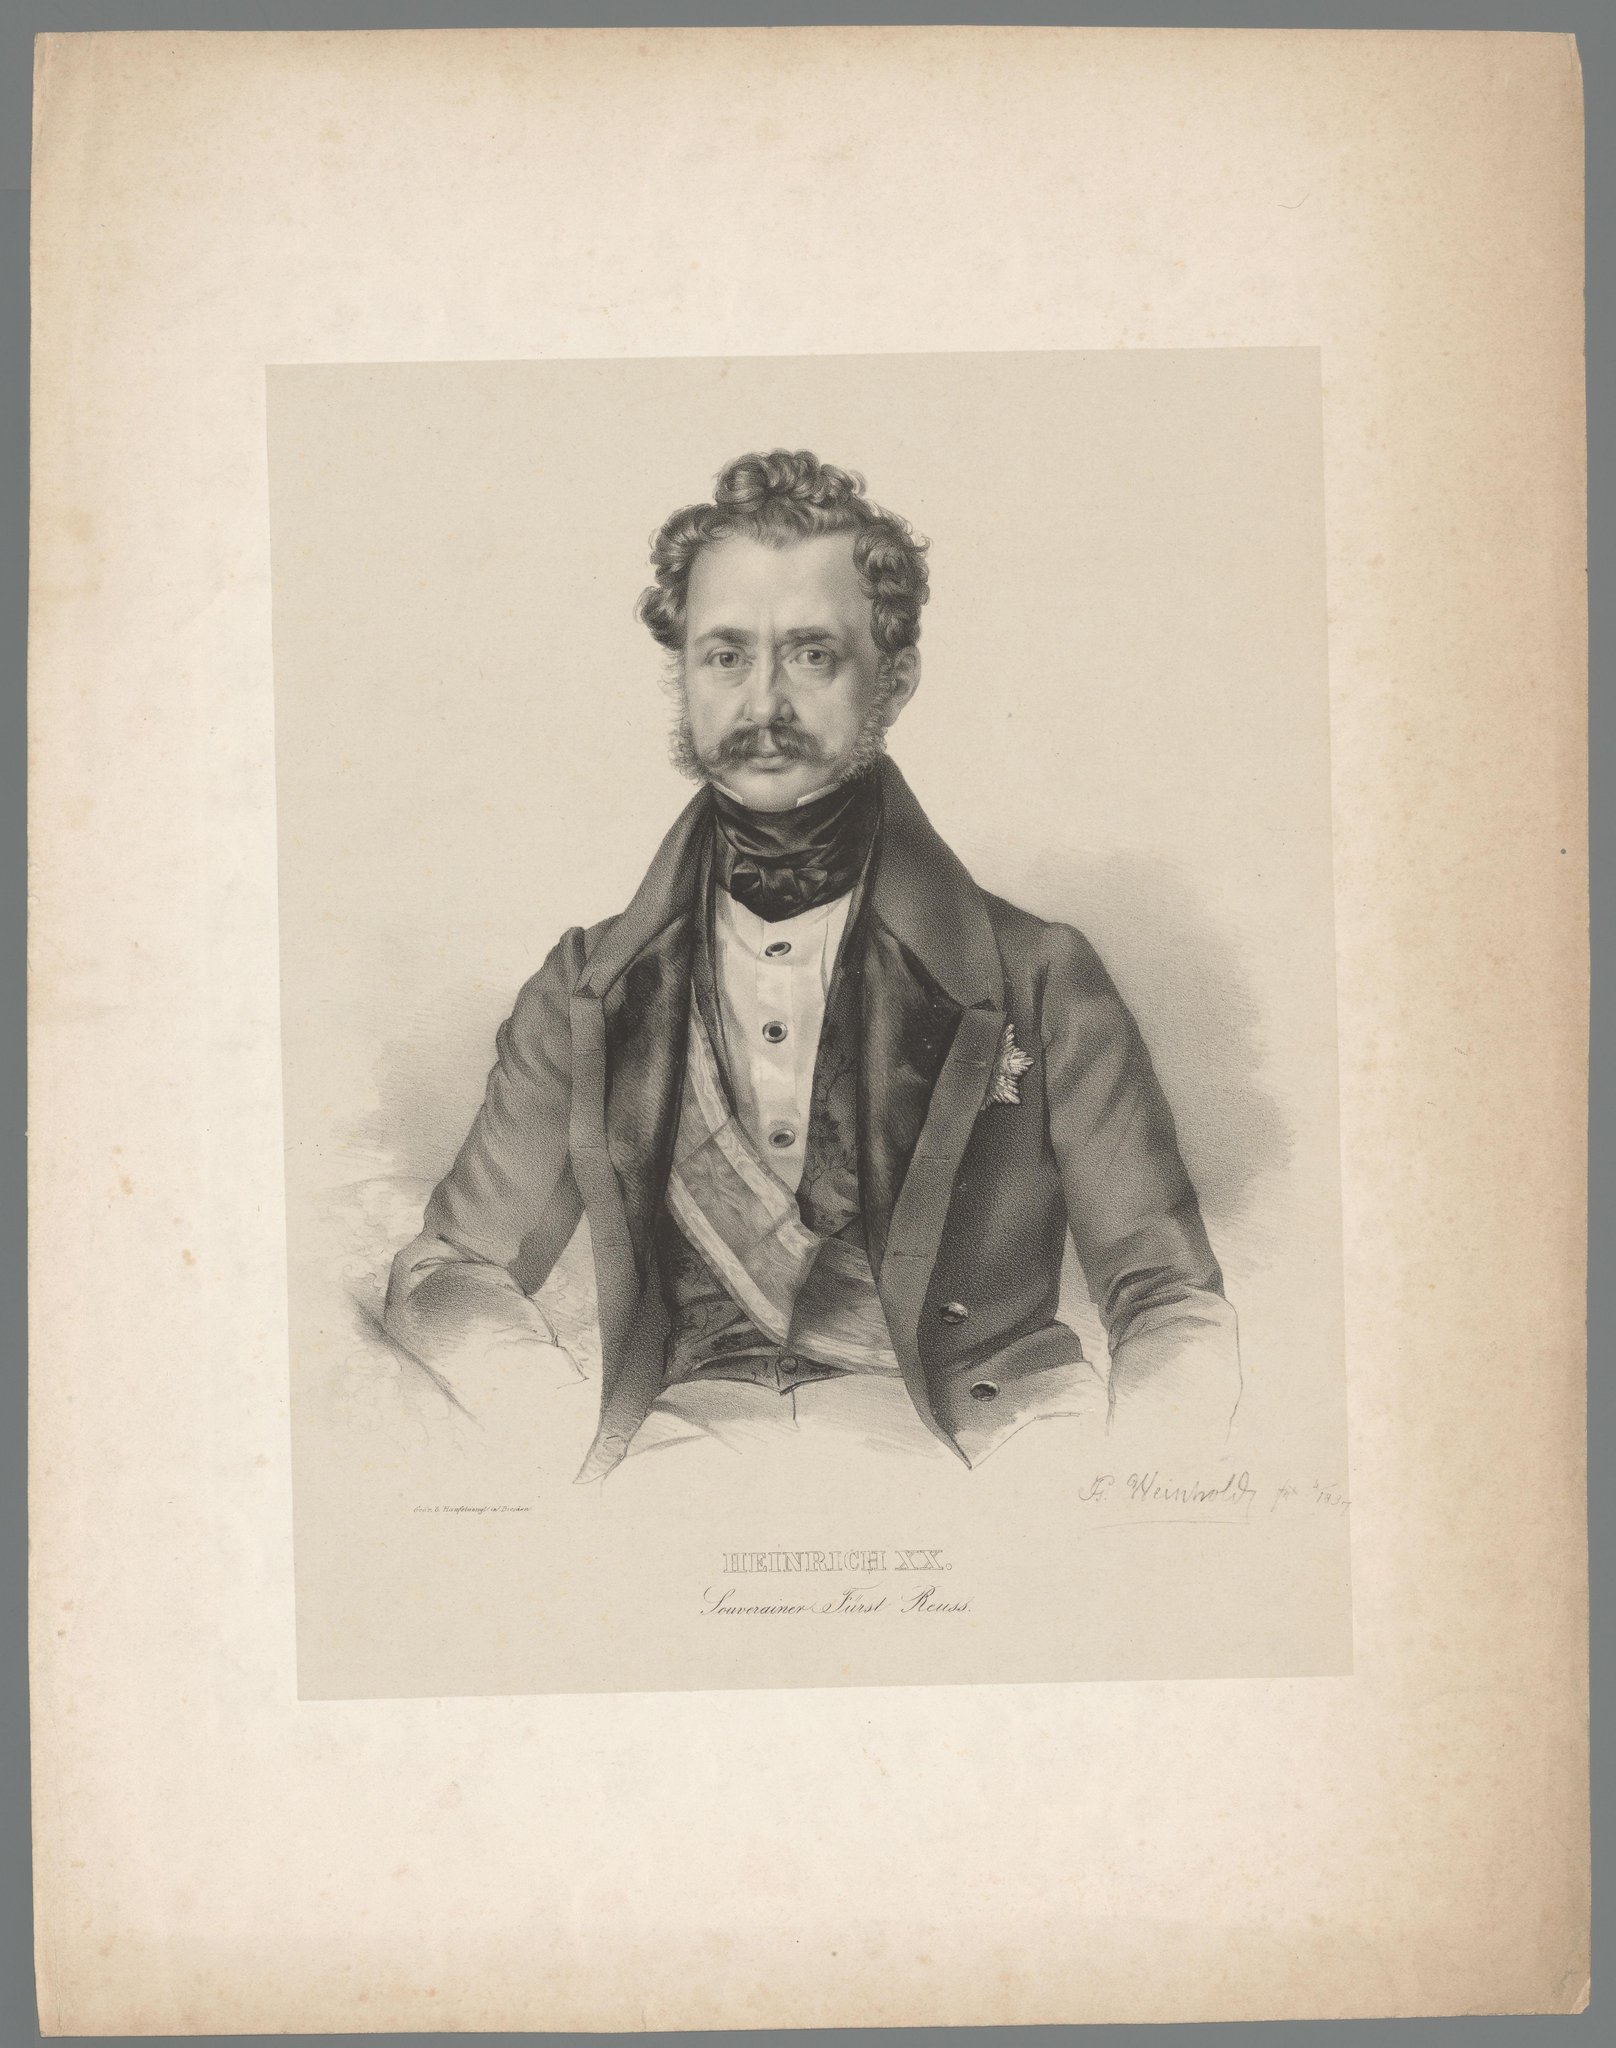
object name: print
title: Portret van Heinrich XX, vorst van Reuss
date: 1837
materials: paper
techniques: lithograph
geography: dresden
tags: adult man, historical persons, beard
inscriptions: collector's mark: Lugt 2228